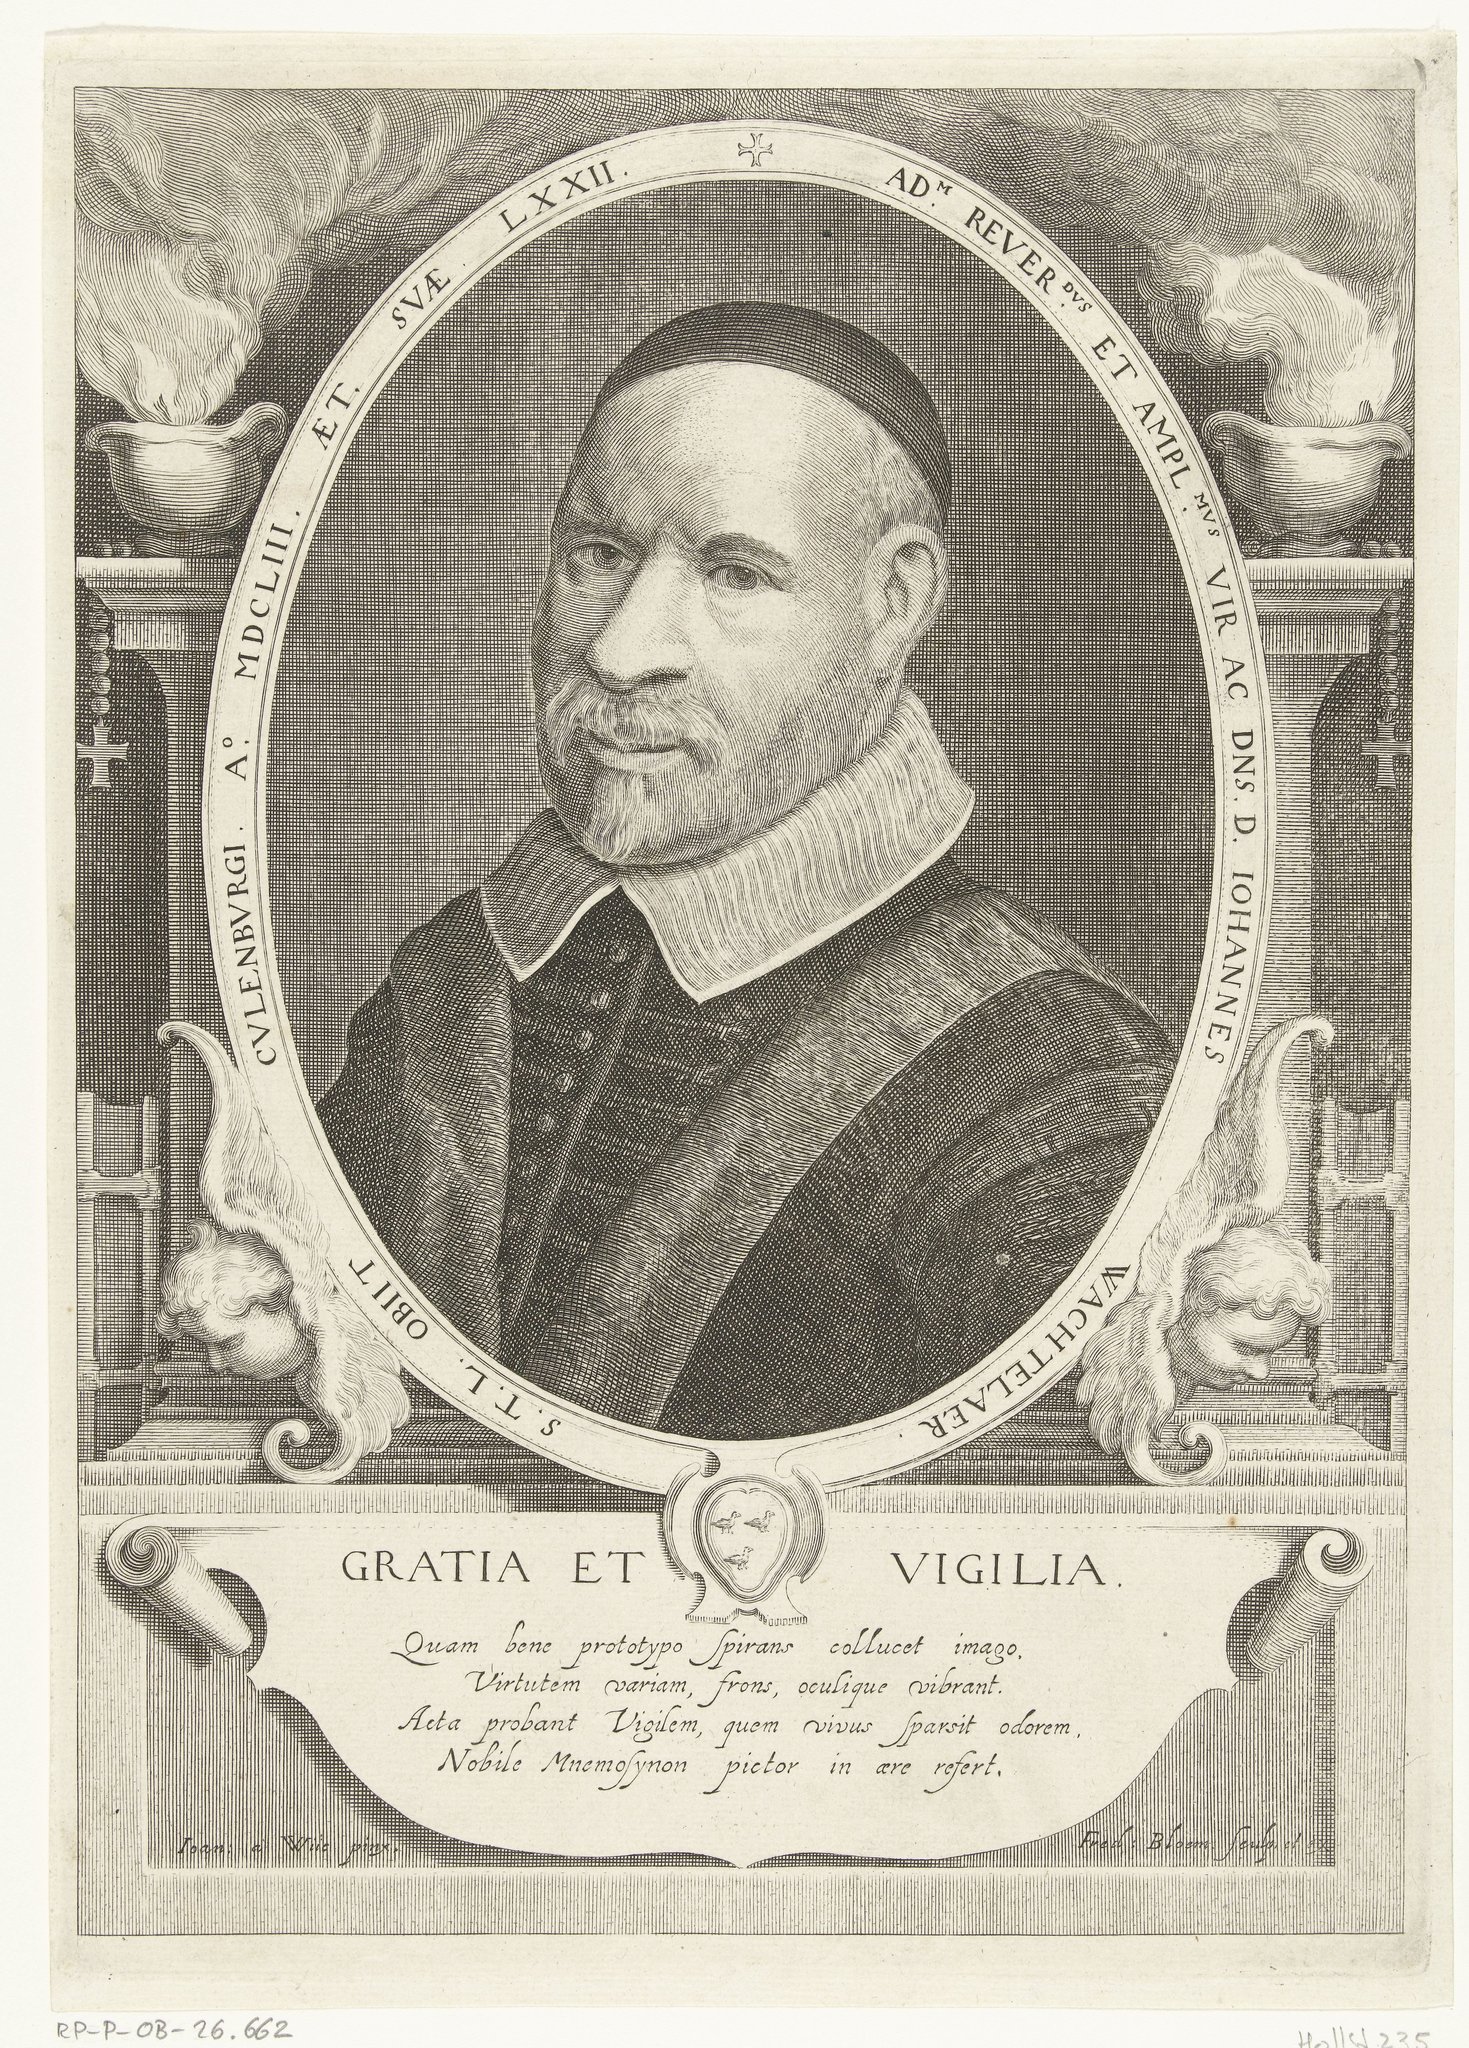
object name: print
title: Portret van Johannes Wachtelaer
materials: paper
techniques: engraving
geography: utrecht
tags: theologian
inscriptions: collector's mark: Lugt 2228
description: Memorieprent voor de theoloog Johannes Wachtelaar. Portret in ovaal met Latijnse randtekst en Latijns onderschrift. Om het ovaal: potten met rook, engelen, rozenkransen en boeken.